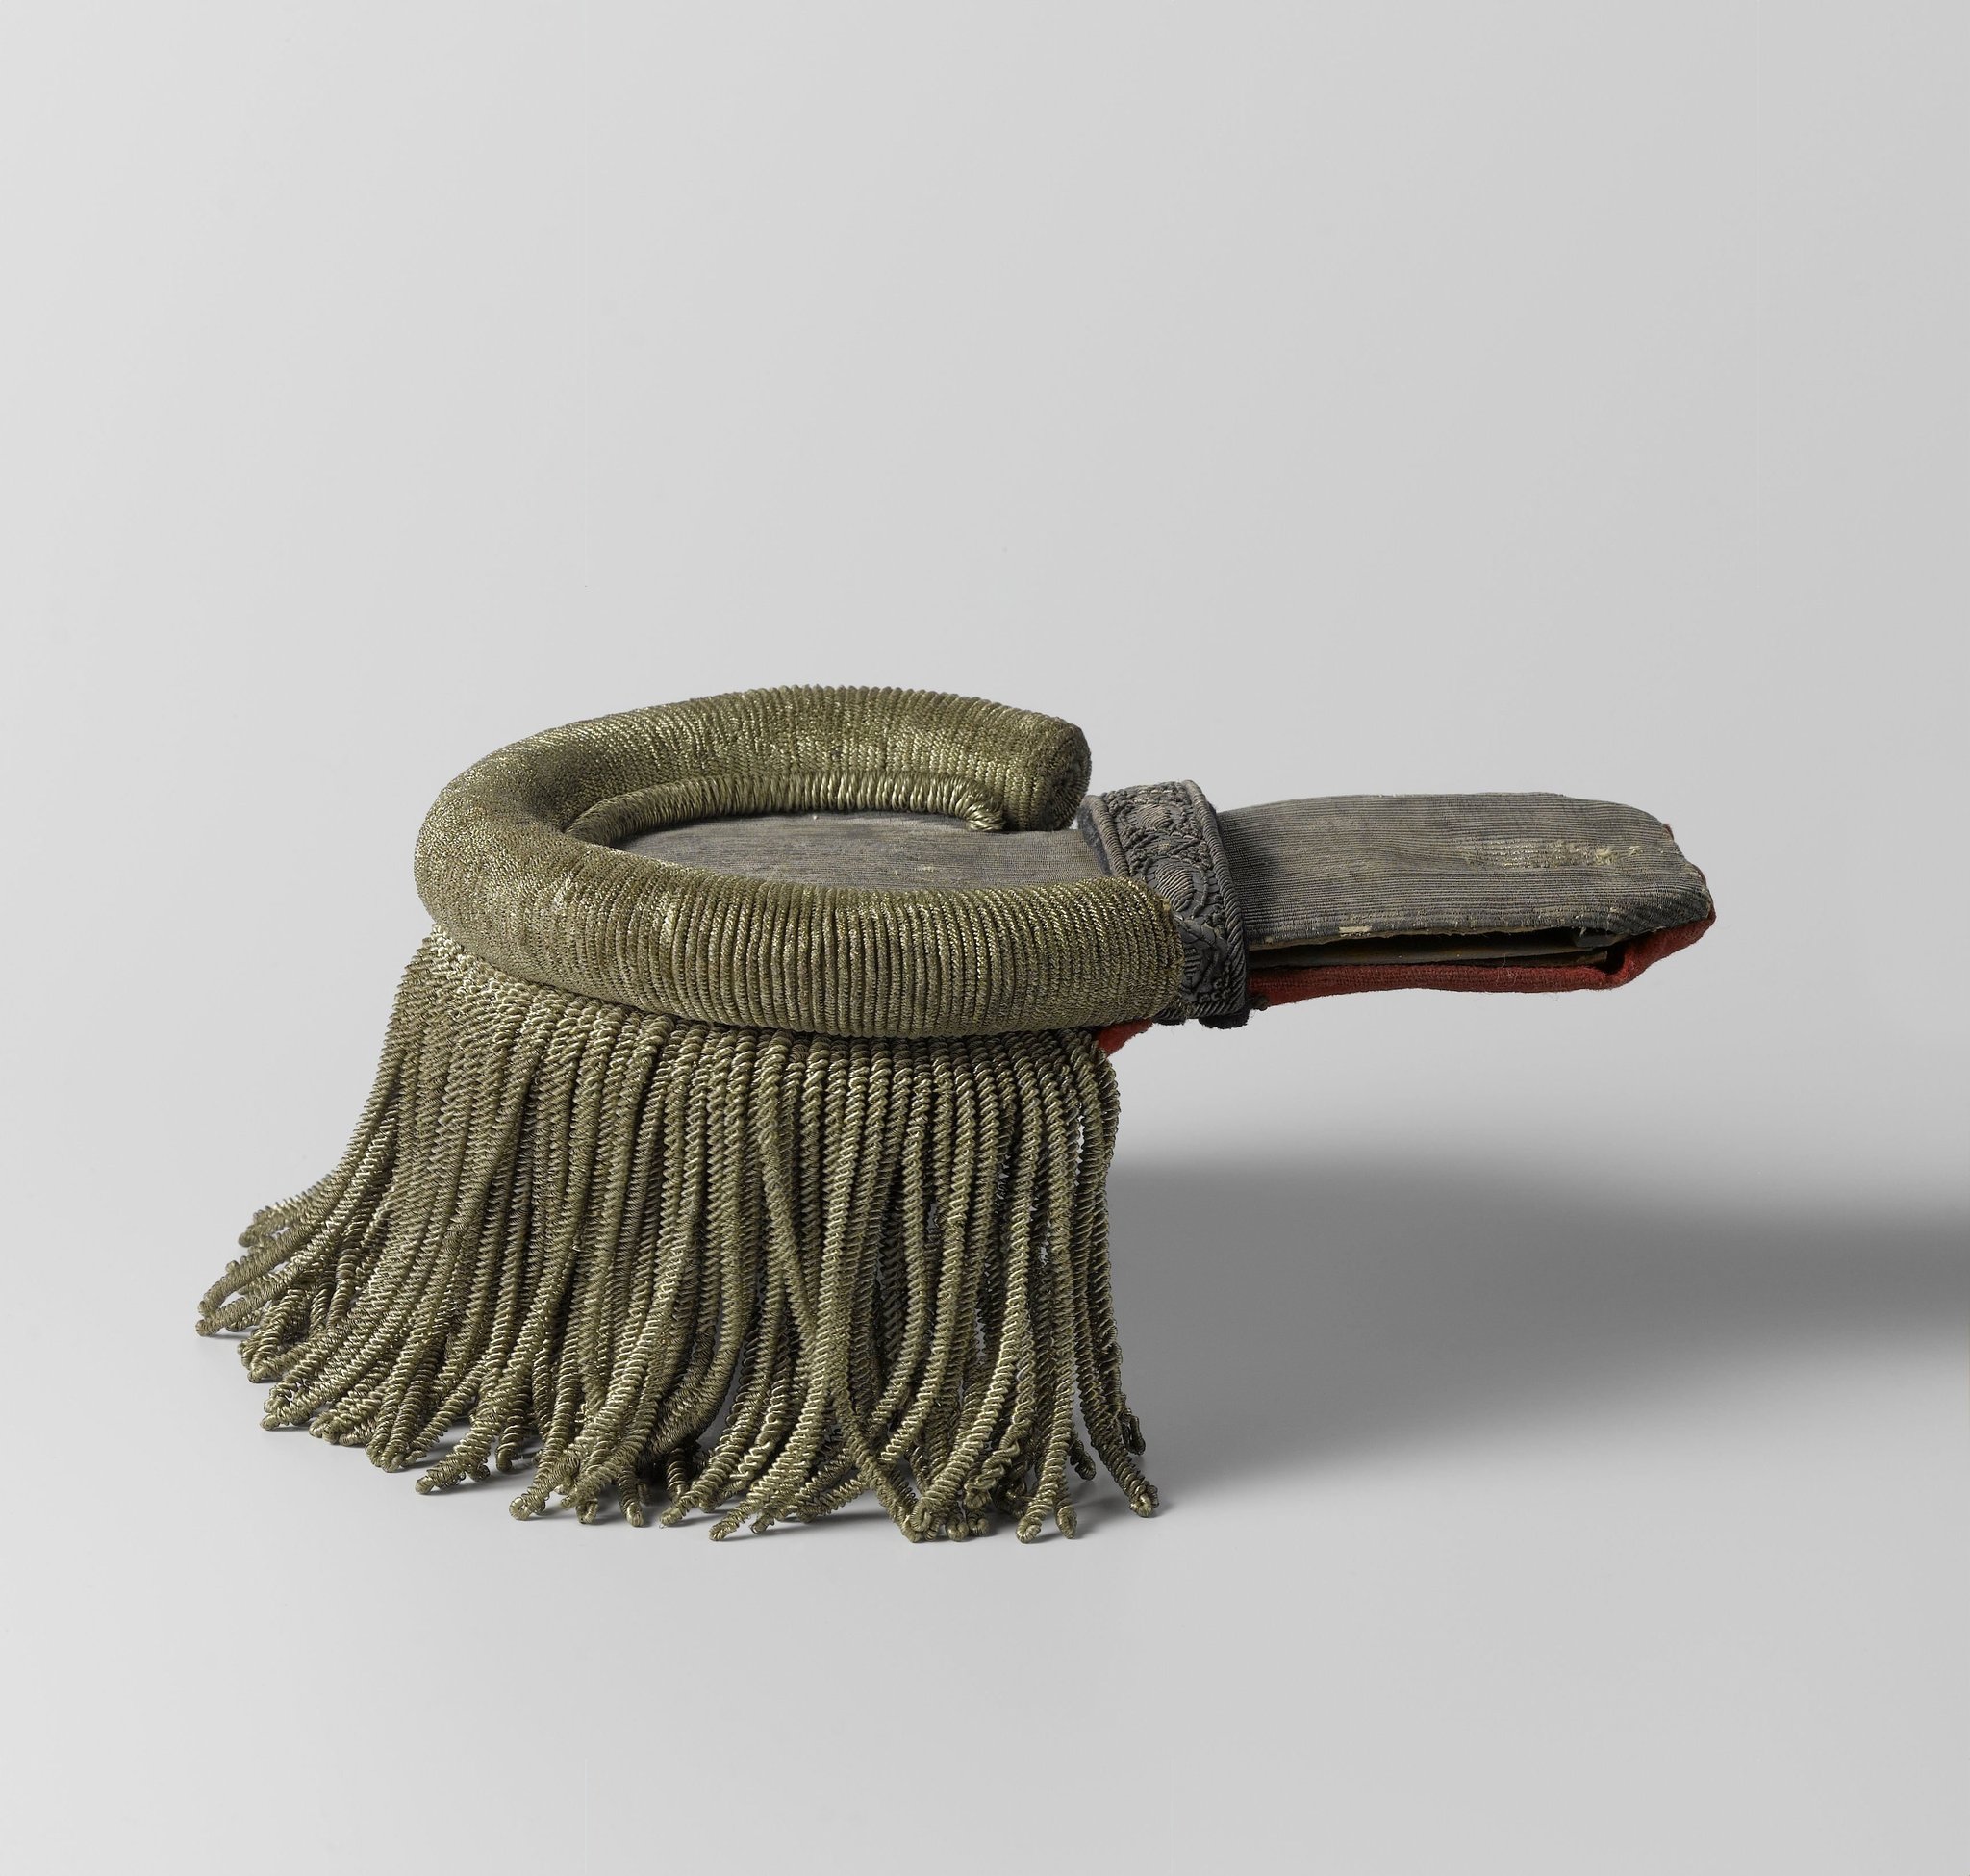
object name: epaulet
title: Epaulet van Jhr. Hoeufft, in 1830/32 kapitein bij de afdeling Schutterij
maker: Anonymous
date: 1830-1832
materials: textile, paper, thread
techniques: stitching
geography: netherlands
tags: amsterdam, netherlands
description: Epaulet, deel van paar, voor een kapitein der mobiele schutterij, ca. 1830-1832. Het epaulet bestaat uit een tong van zilvergalon, waarover een schuifpassant is gemonteerd, bestaand uit een borduursel van zilverdraad en pailetten, met een voering van donkerblauw laken. Dit epaulet heeft een achthoekig etiket op de tong geplakt, waarop nr. 133. (dit etiket was niet meer zichtbaar bij de controle in 2010) Het blad van het epaulet is voorzien van een min of meer ovaal etiket waarop in inkt de tekst staat: jonkheer Hoeufft. 1830-1832. kapitein schutterij 133. Aan het blad afhangende zilveren franje. onderzijdes zijn gevoerd met rood laken, waarop voer restanten van papieren etiketten met deels leesbare tekst: In de...straat....Heiligenweg...van den Broecke...maakt en verkoopt alle soorten van militaire ornamenten etc. etc. te Amsterdam.